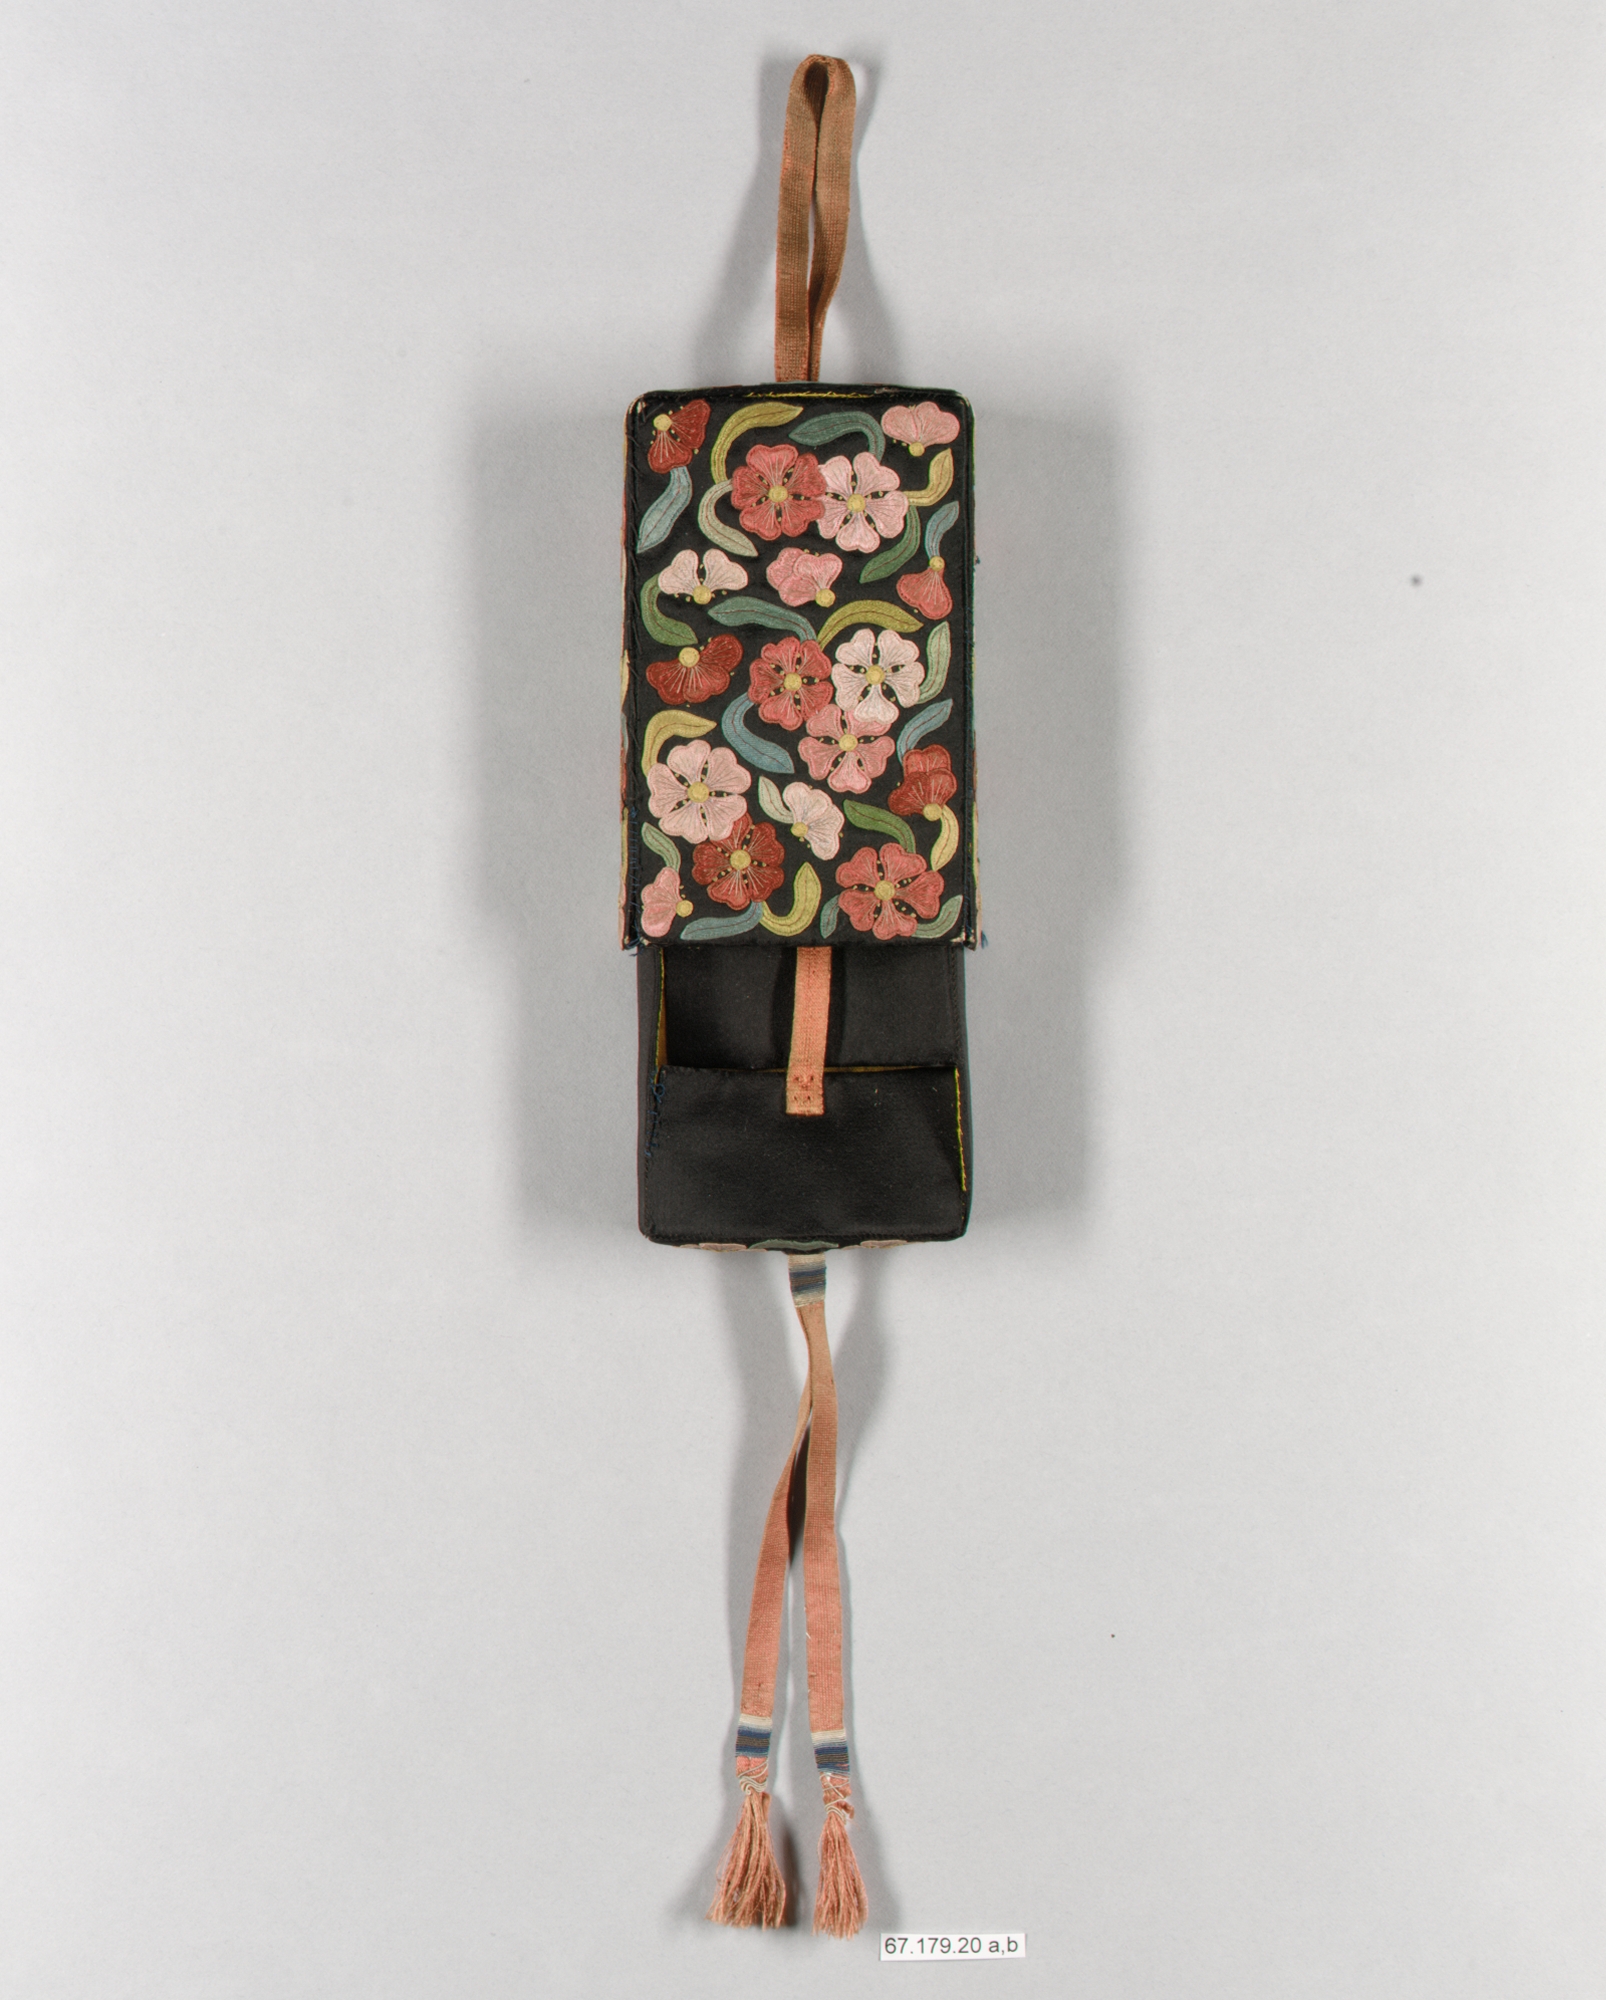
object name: case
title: Embroidered Case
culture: chinese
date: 1801-1900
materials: silk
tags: flowers